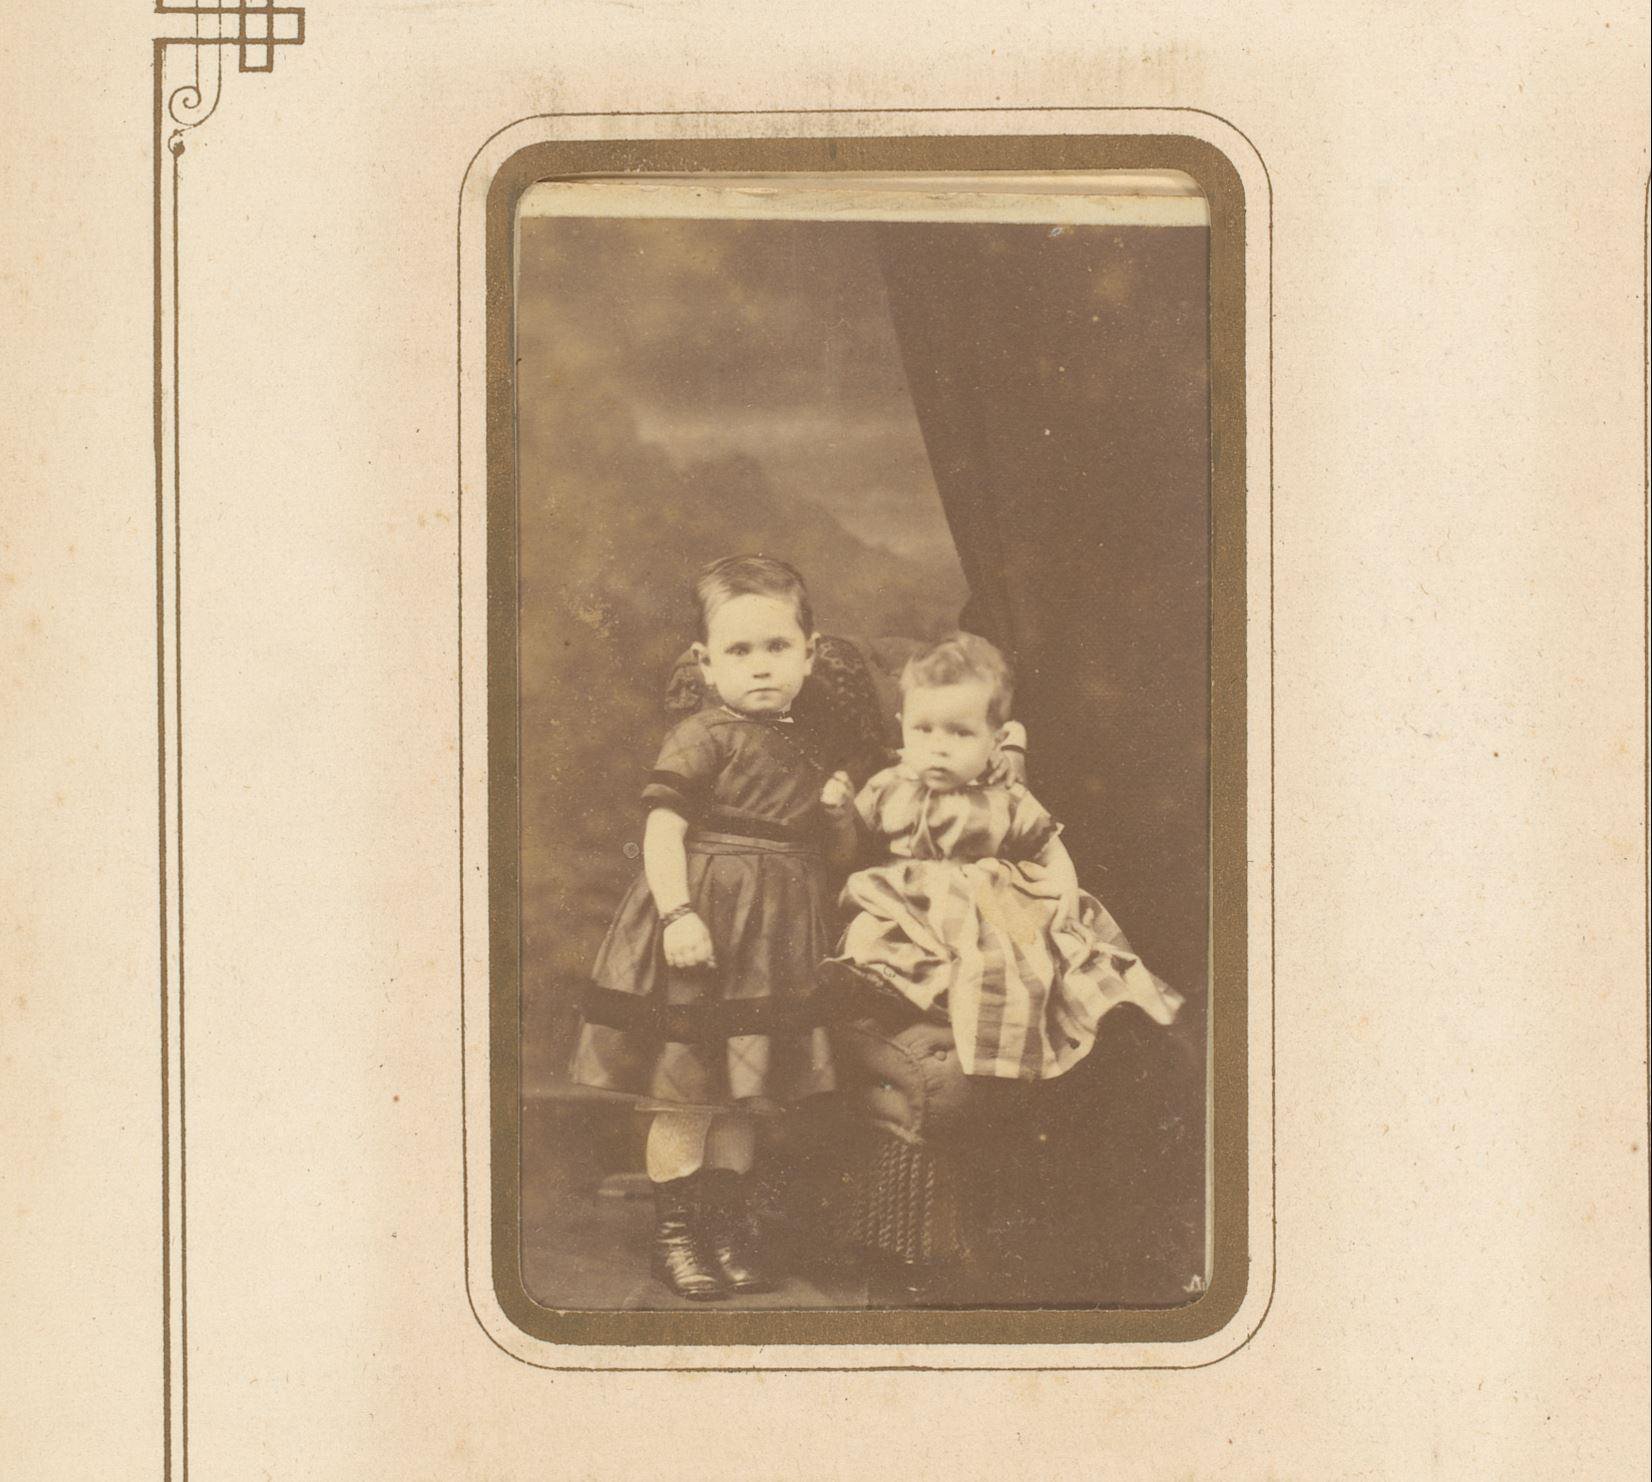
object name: photograph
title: Portret van twee kinderen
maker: Anonymous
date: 1883-1910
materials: cardboard, photographic support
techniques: albumen print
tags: historical persons, youth, adolescent